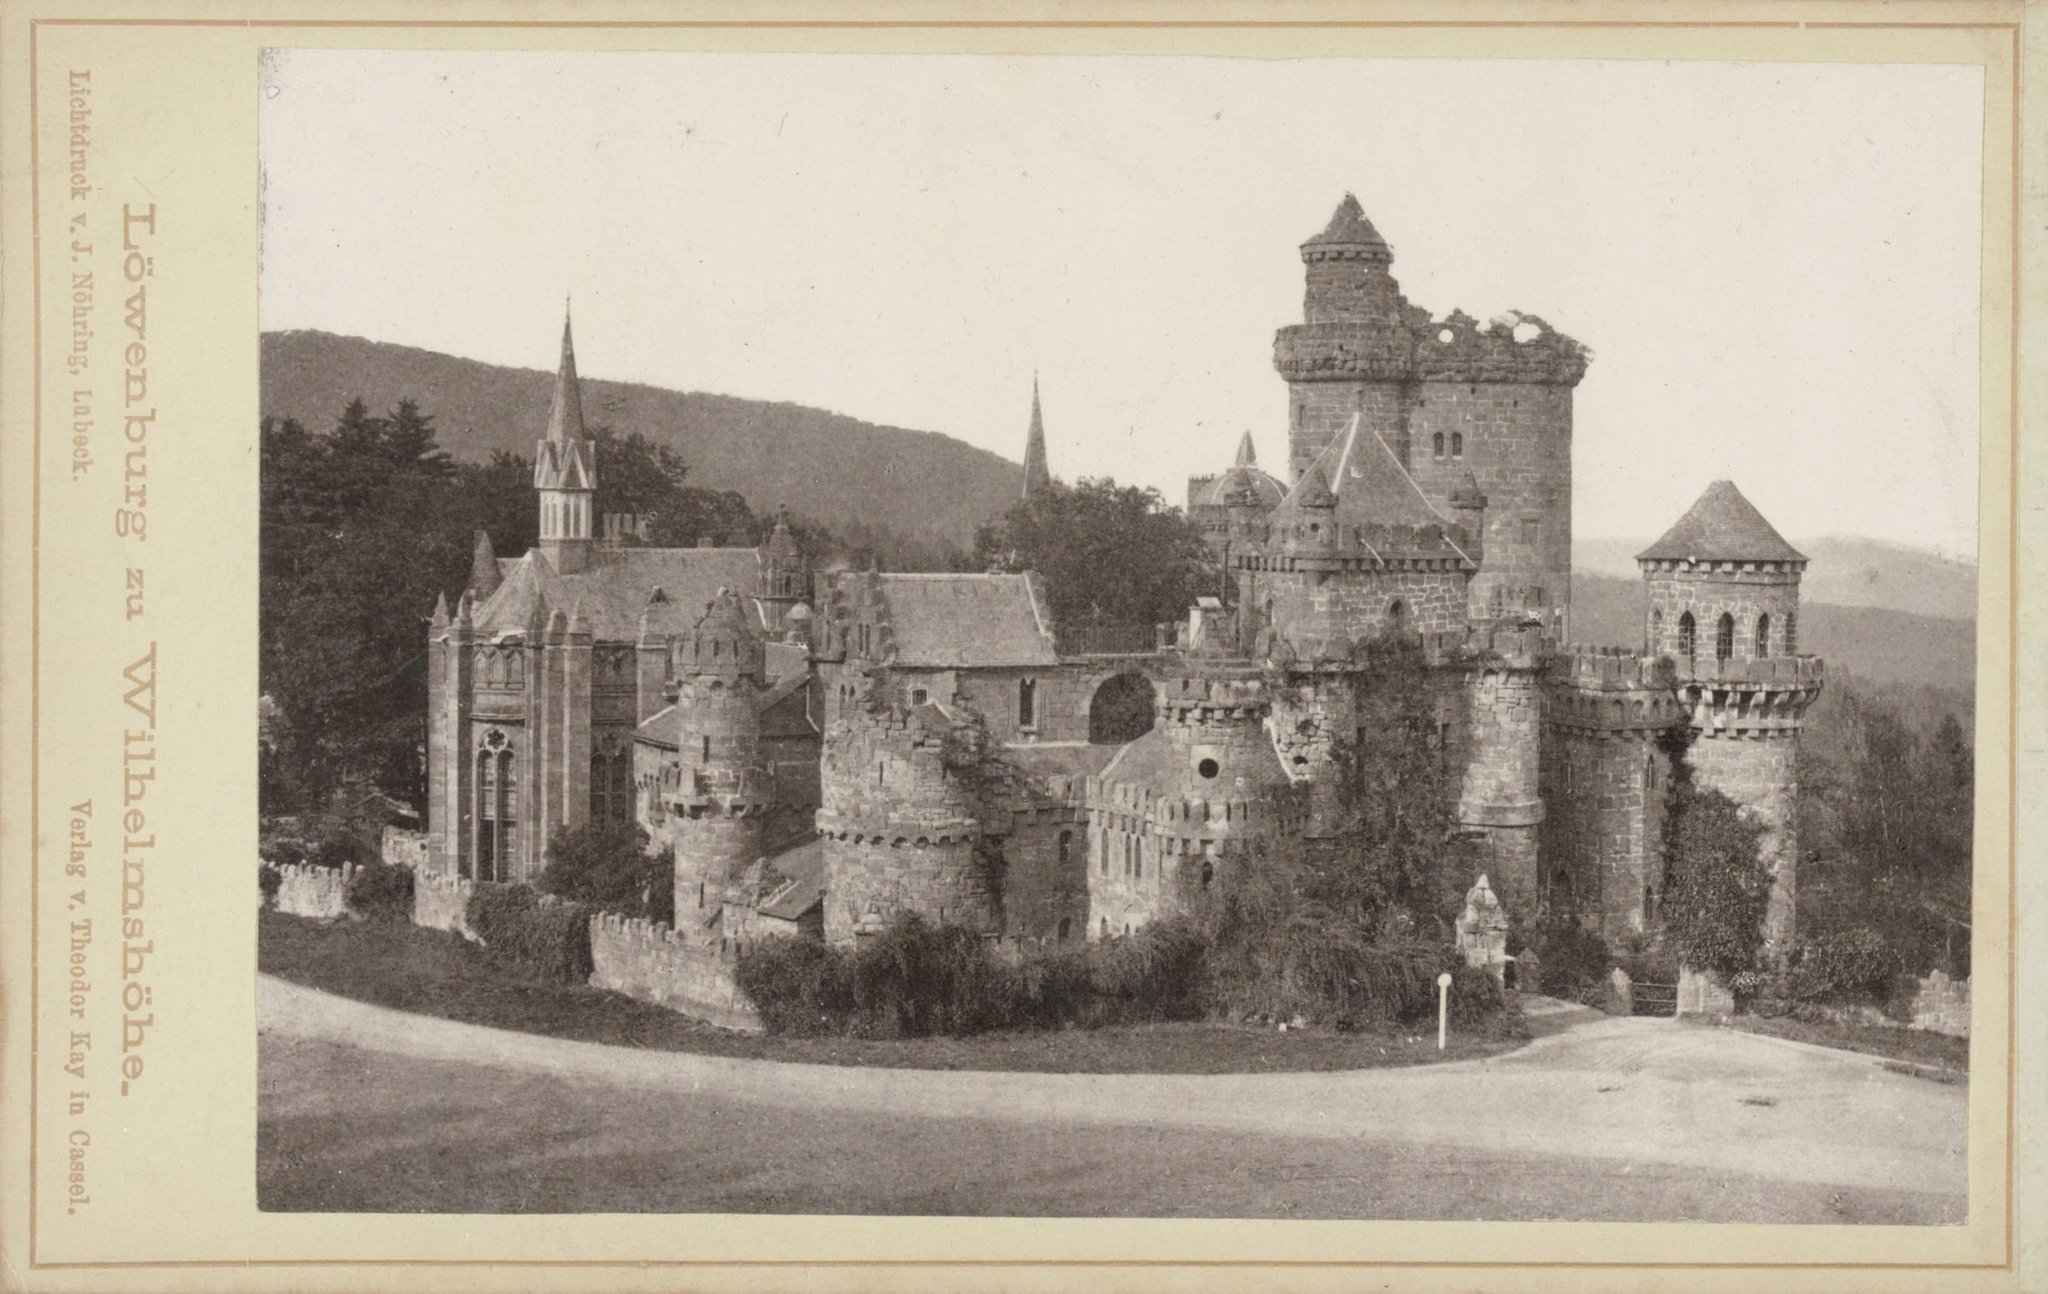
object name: cabinet photograph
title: Löwenburg zu Wilhelmshöhe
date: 1870-1890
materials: cardboard, paper, photographic support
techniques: photograph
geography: kassel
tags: travelling; tourism, ruin of a dwelling, house, castle, etc.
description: Onderdeel van Album met 38 foto's van een reis door de Harz.